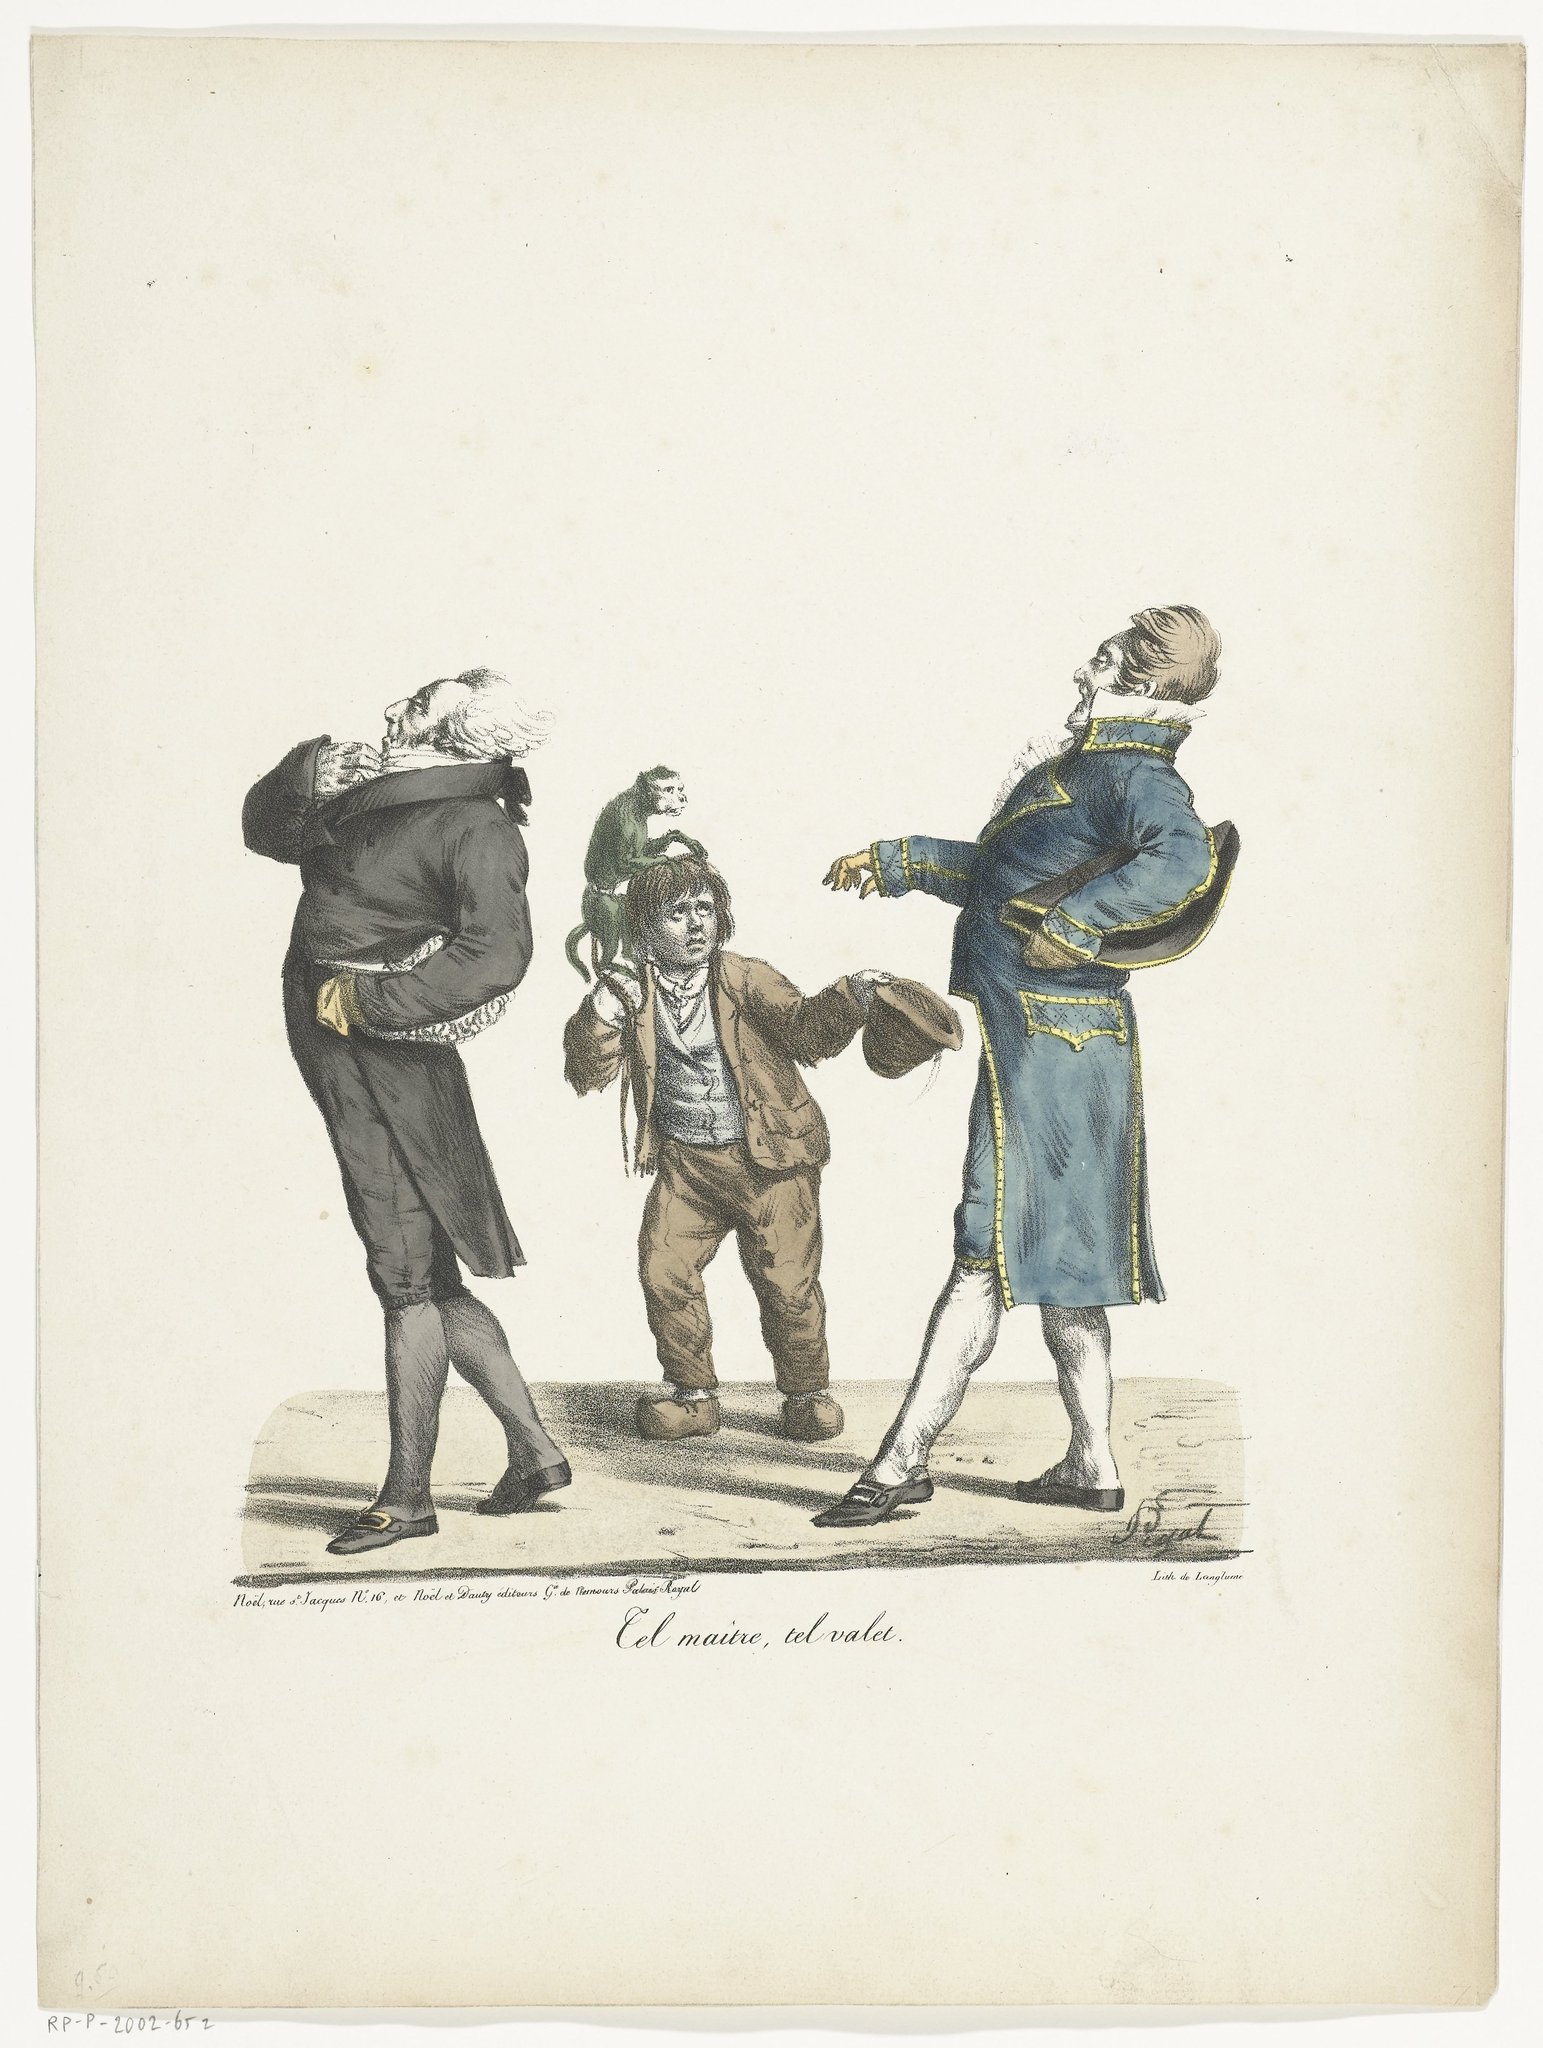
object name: print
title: Man en zijn bediende lopen hooghartig langs bedelende jongen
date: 1818-1830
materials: paper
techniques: hand coloring, lithograph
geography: paris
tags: relation between master and servant, beggar, earning money with monkey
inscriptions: collector's mark: Lugt 2228